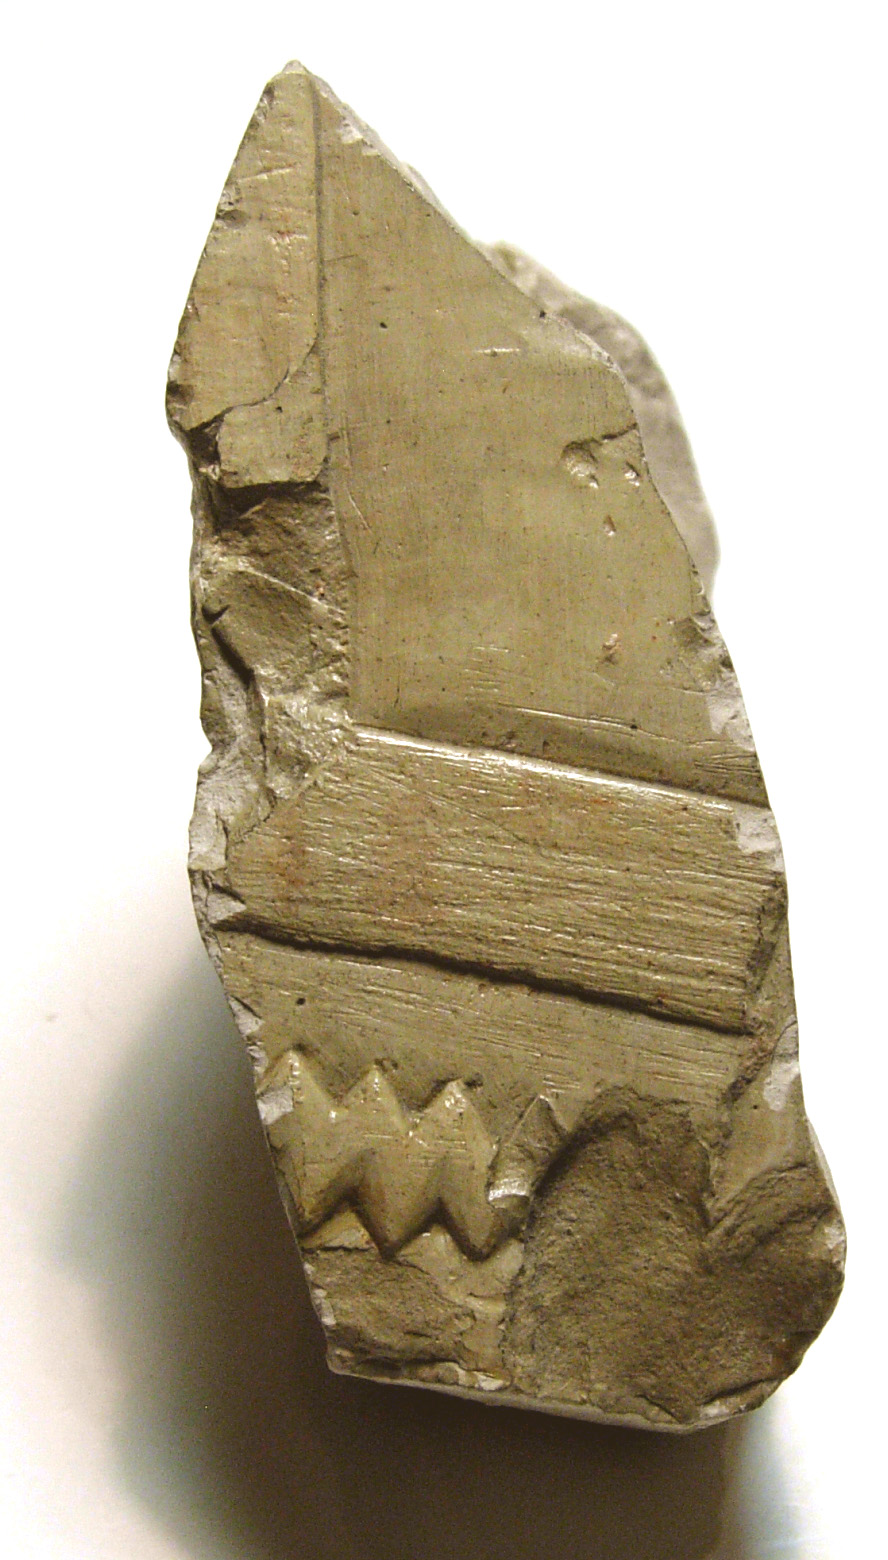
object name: relief, tomb of nespekashuty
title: Raised relief fragment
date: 664-610 BCE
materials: limestone, varnish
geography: egypt